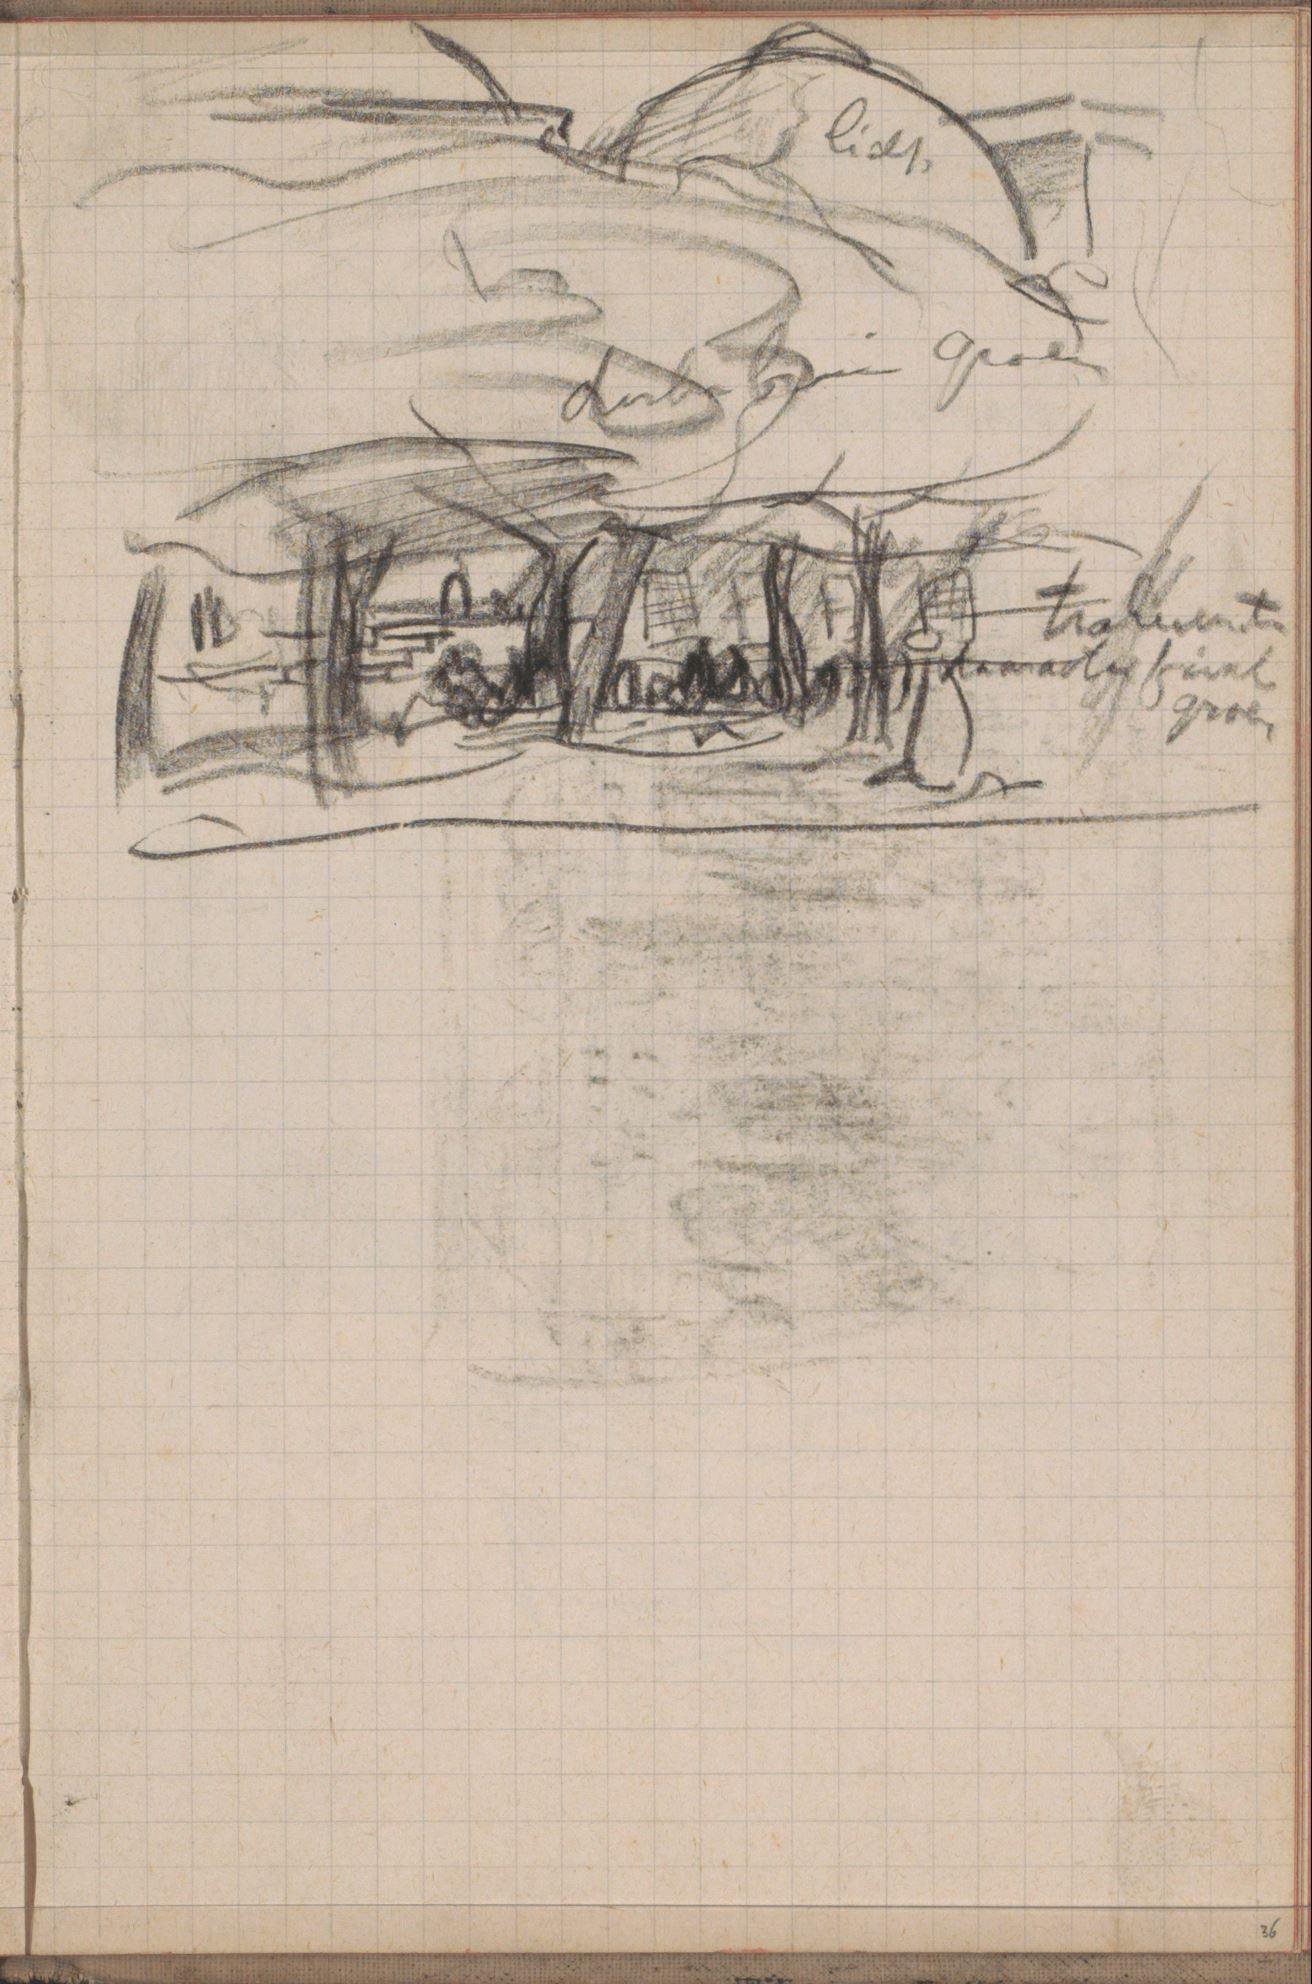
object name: sketchbook leaf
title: Landschap met figuren onder de bomen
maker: marius bauer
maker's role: draughtsman, print maker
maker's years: 1867-1932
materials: chalk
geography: istanbul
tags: trees, landscapes (+ landscape with figures, staffage)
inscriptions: kleurnotitie, handgeschreven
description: Pagina 36 uit een schetsboek met 54 bladen.